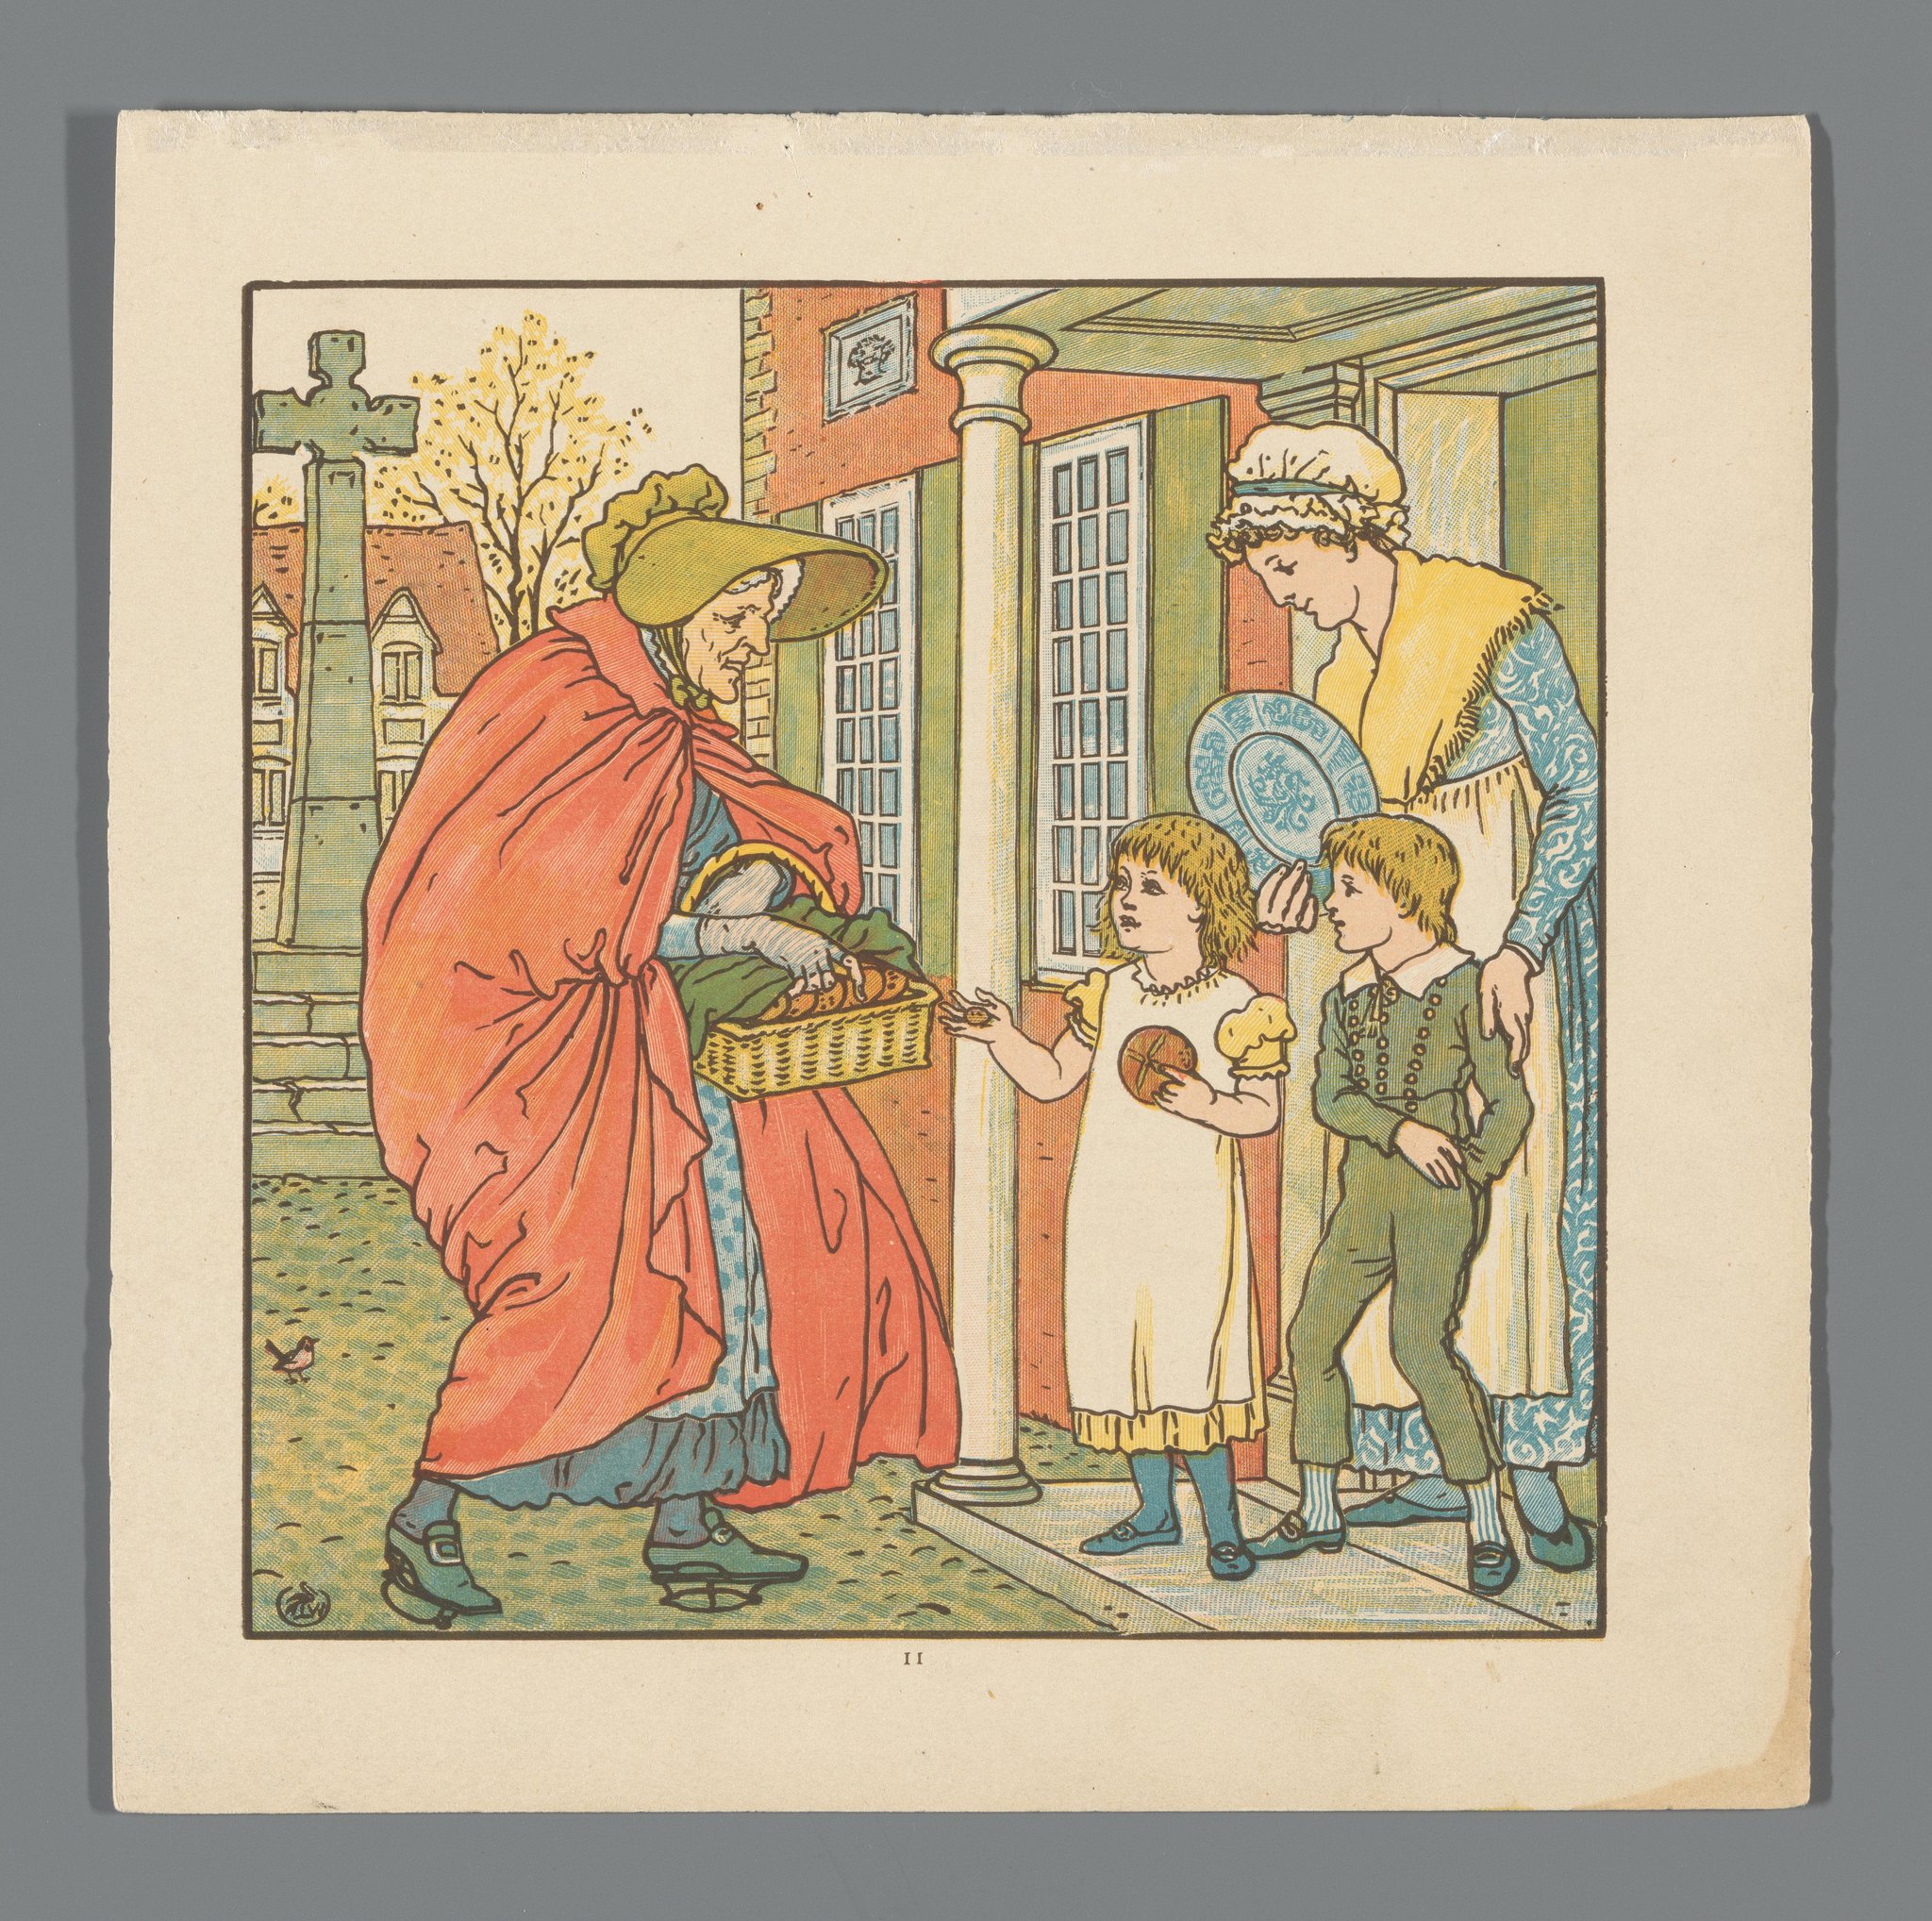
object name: book illustration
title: Verkoopster bij een huis met vrouw en twee kinderen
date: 1878-1927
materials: paper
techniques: wood engraving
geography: london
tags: old woman, buying and selling, mother and child(ren), woman and child(ren) (family group)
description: Prent uit: The baby's bouquet, a fresh bunch of old rhymes and tunes. Londen: Routledge & Sons, [1878]. Of een latere uitgave.